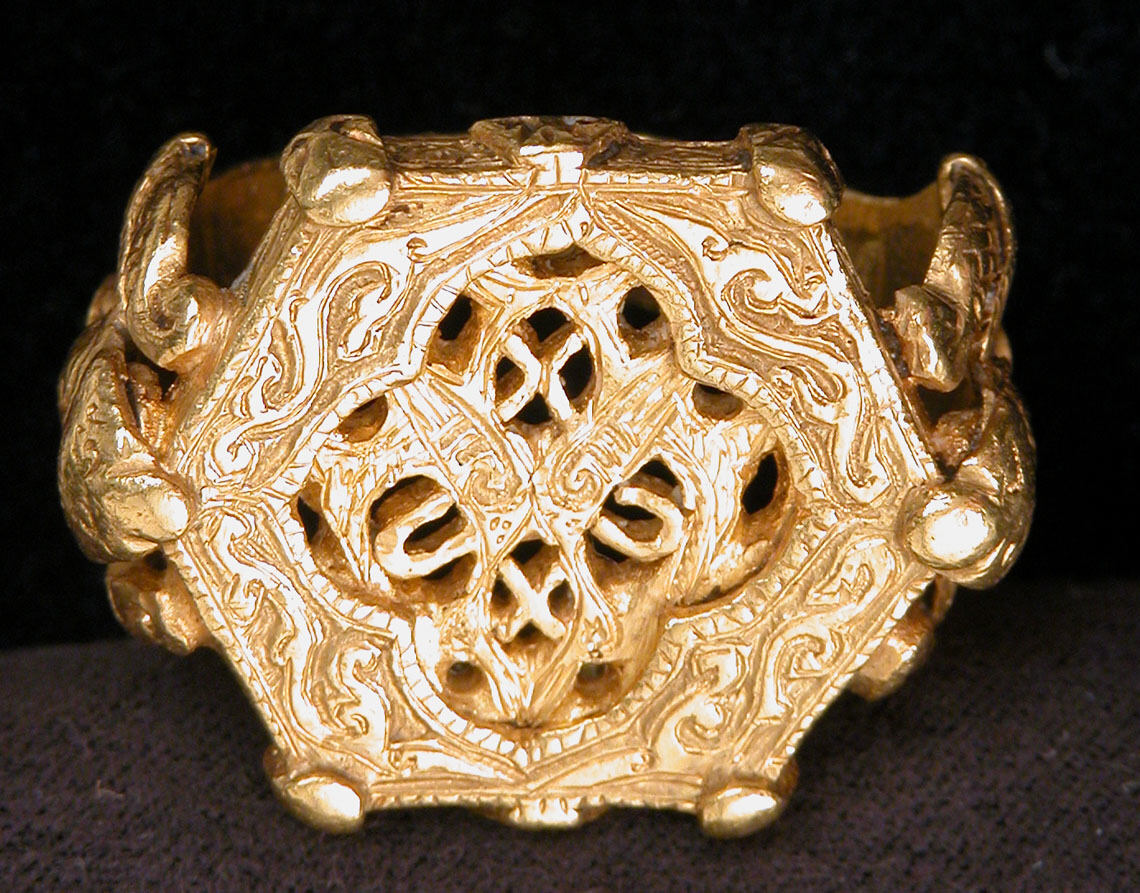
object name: ring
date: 1101-1300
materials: gold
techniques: casting, chasing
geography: iraq